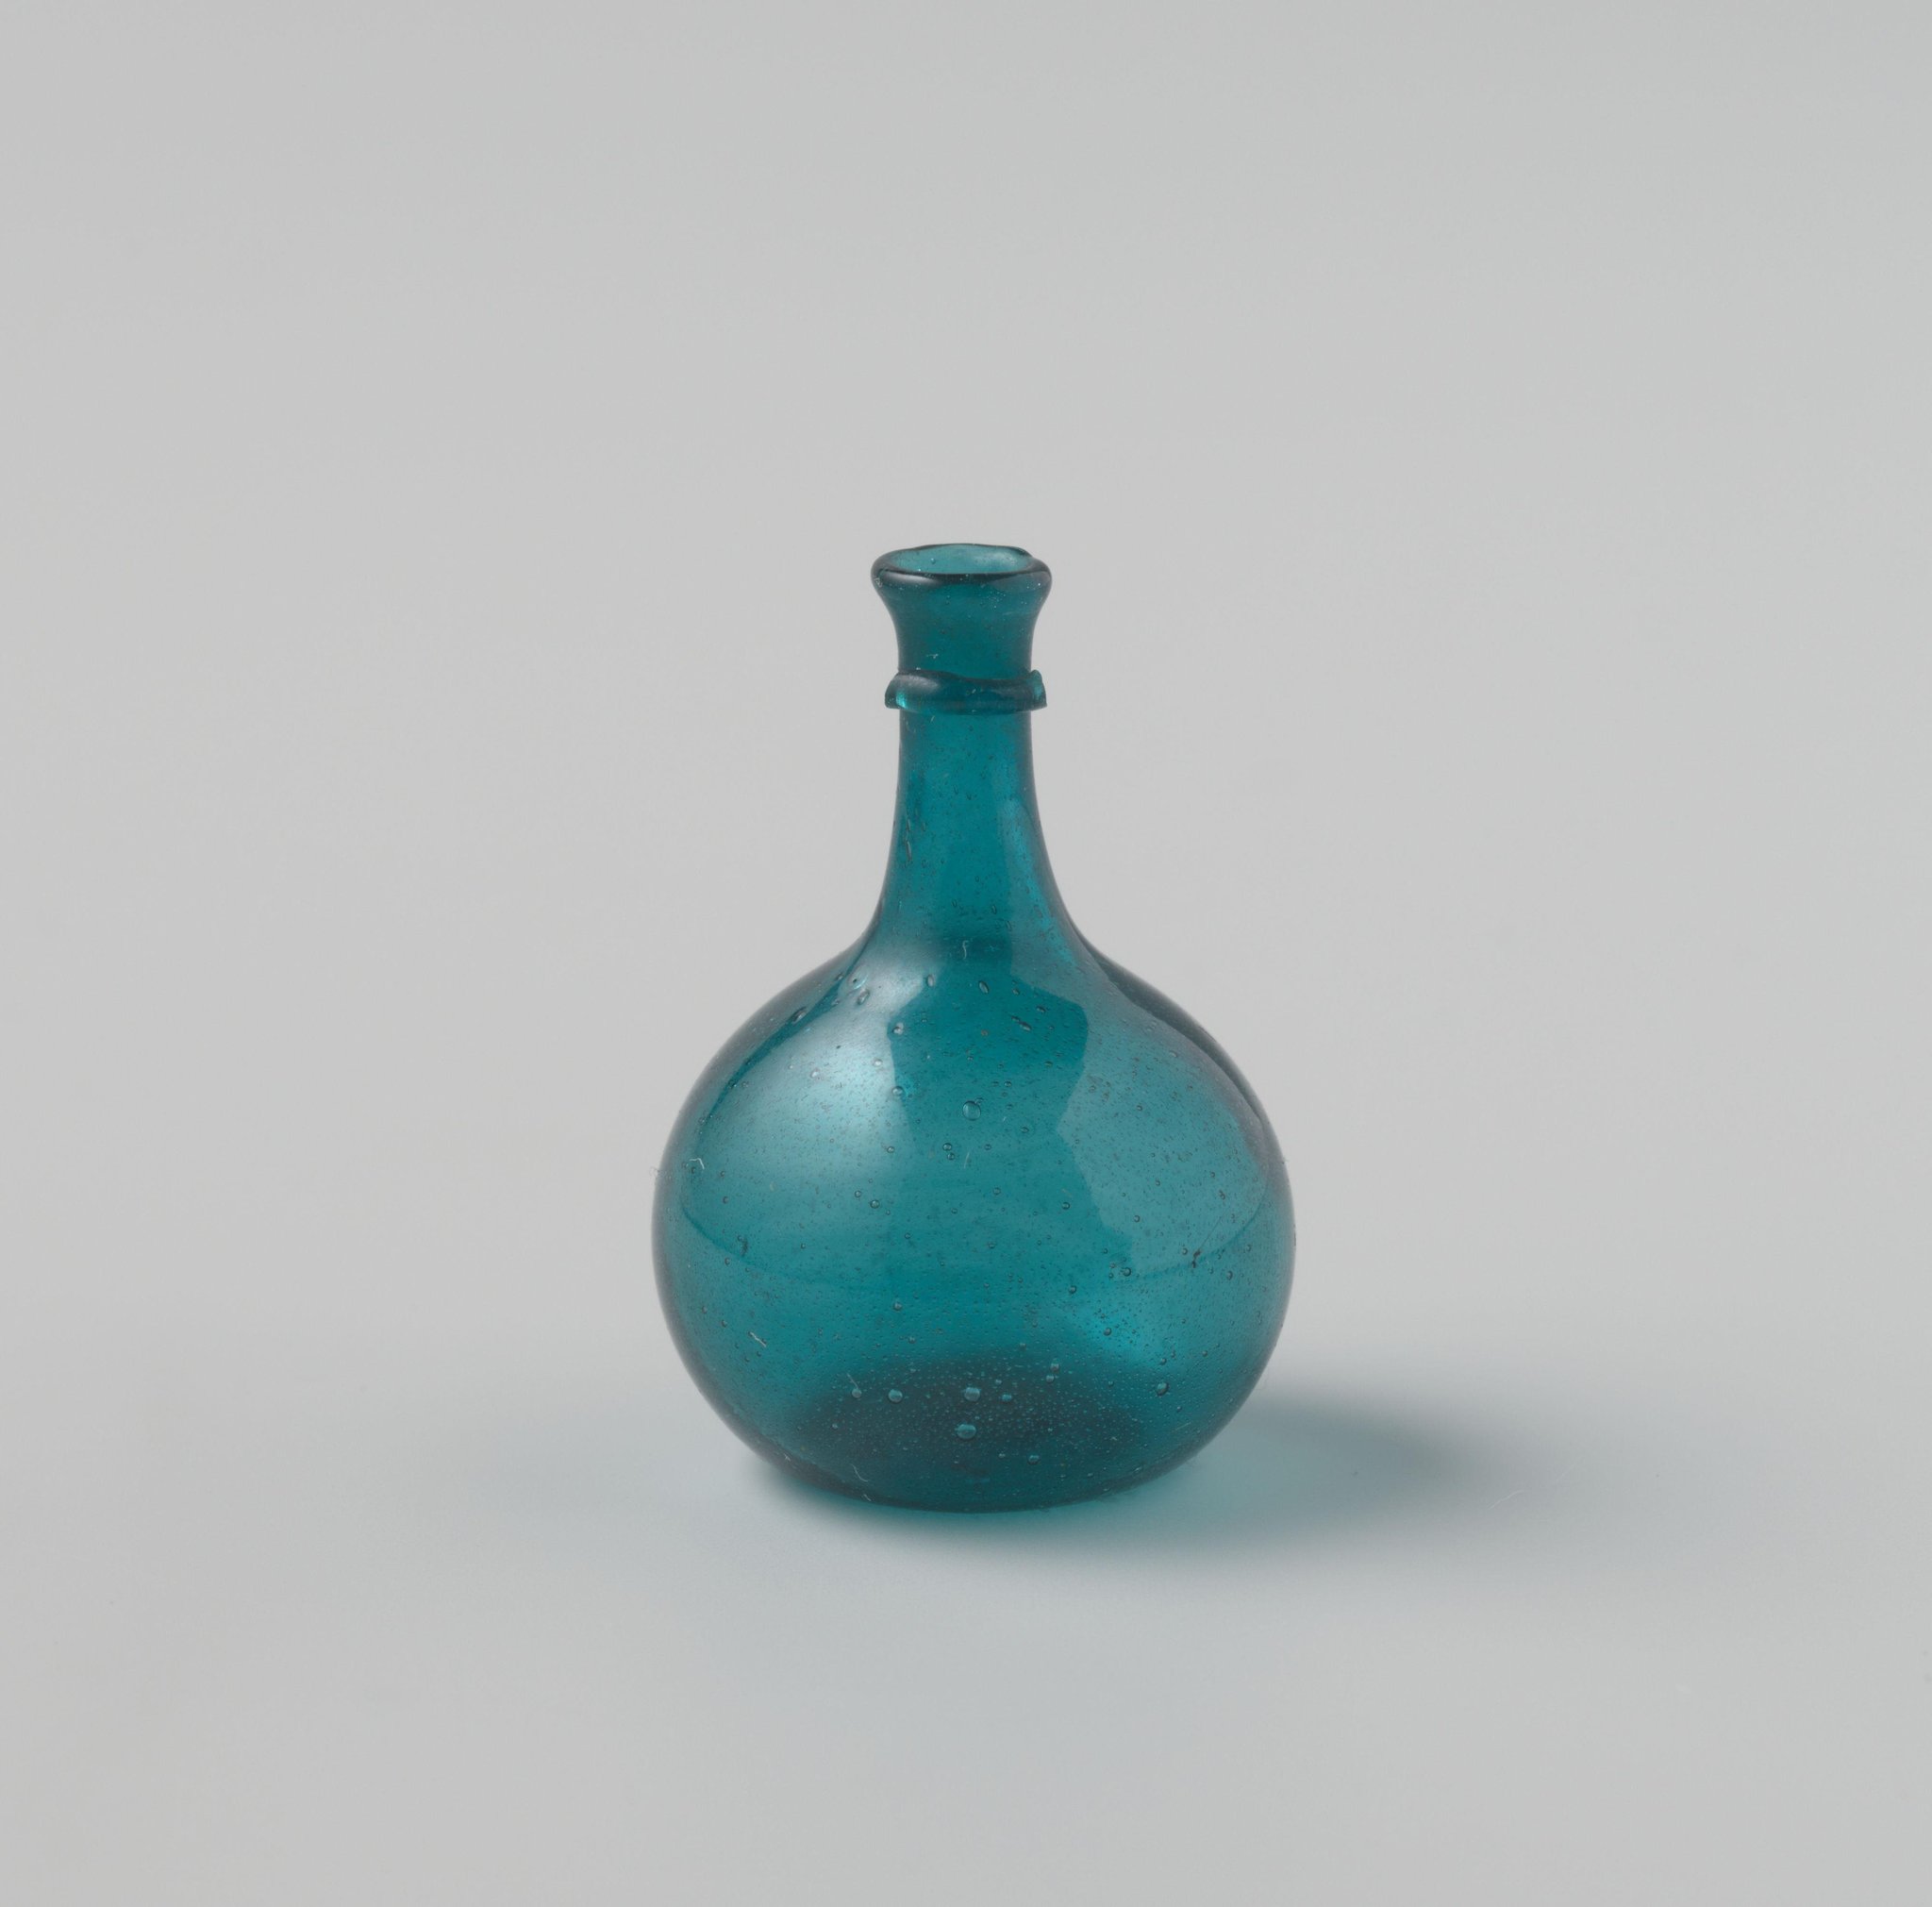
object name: bottle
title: Fles van helder azuurblauw glas; buik met ingestoken ziel, hoge hals met druipring.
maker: Anonymous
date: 1675-1710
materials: glass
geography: amsterdam